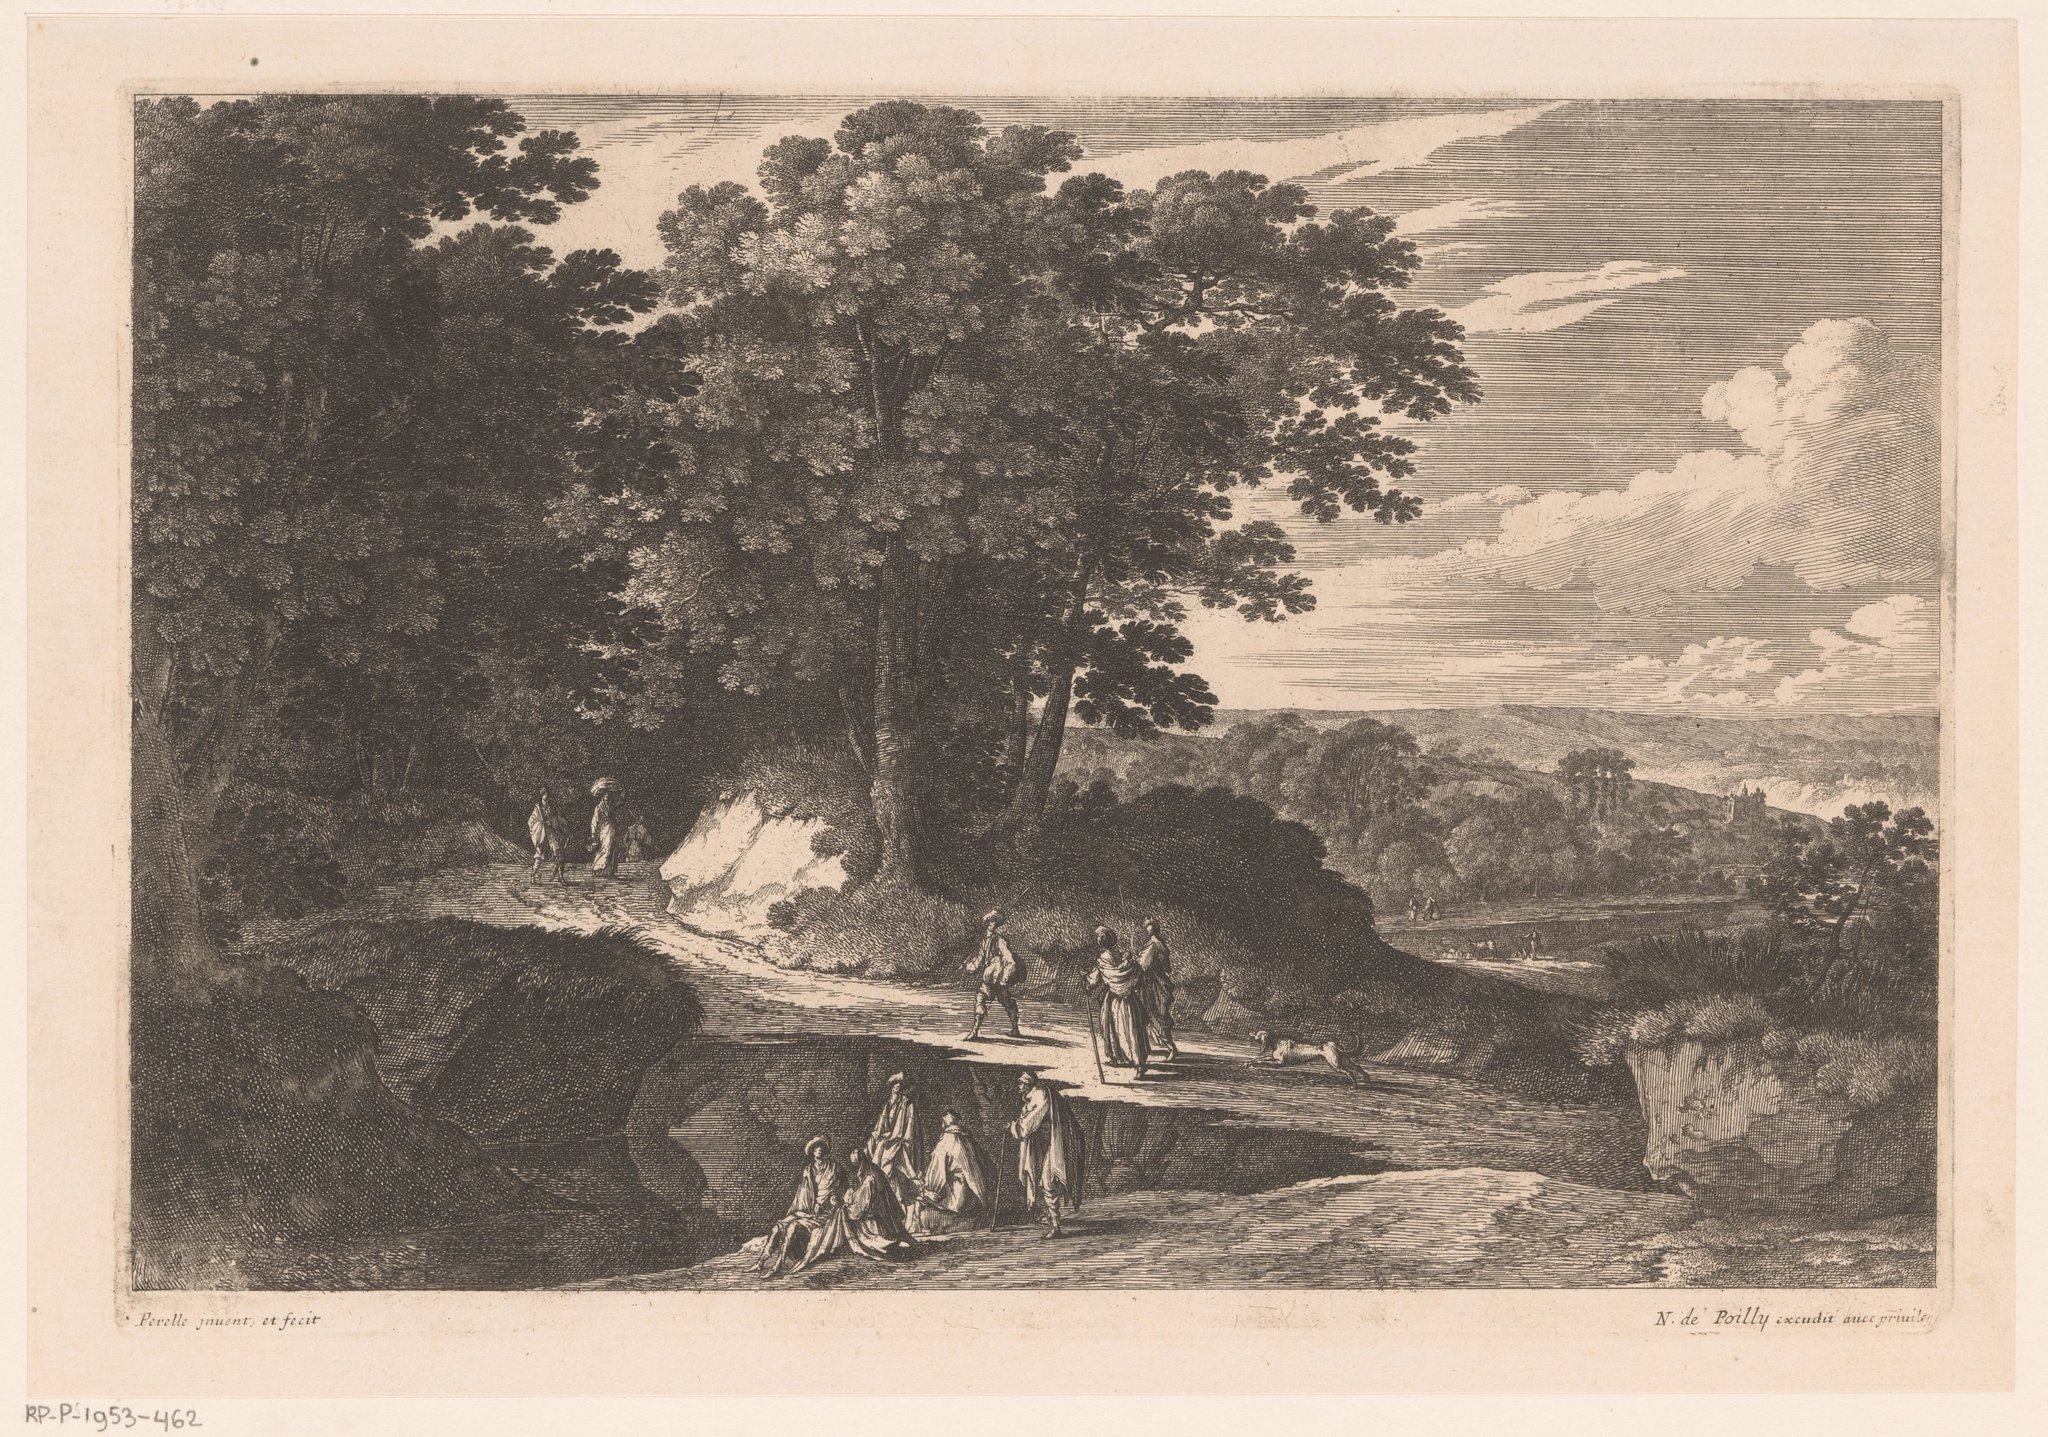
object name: print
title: Landschap met een groep zittende figuren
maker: nicolas de poilly (i)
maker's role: print maker, publisher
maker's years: 1626-1696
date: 1636-1695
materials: paper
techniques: engraving, etching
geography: paris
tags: landscapes (+ landscape with figures, staffage)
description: Prenten met het signatuur 'Perelle' kunnen zowel door vader Gabriel als door zonen Nicolas en Adam gemaakt zijn.